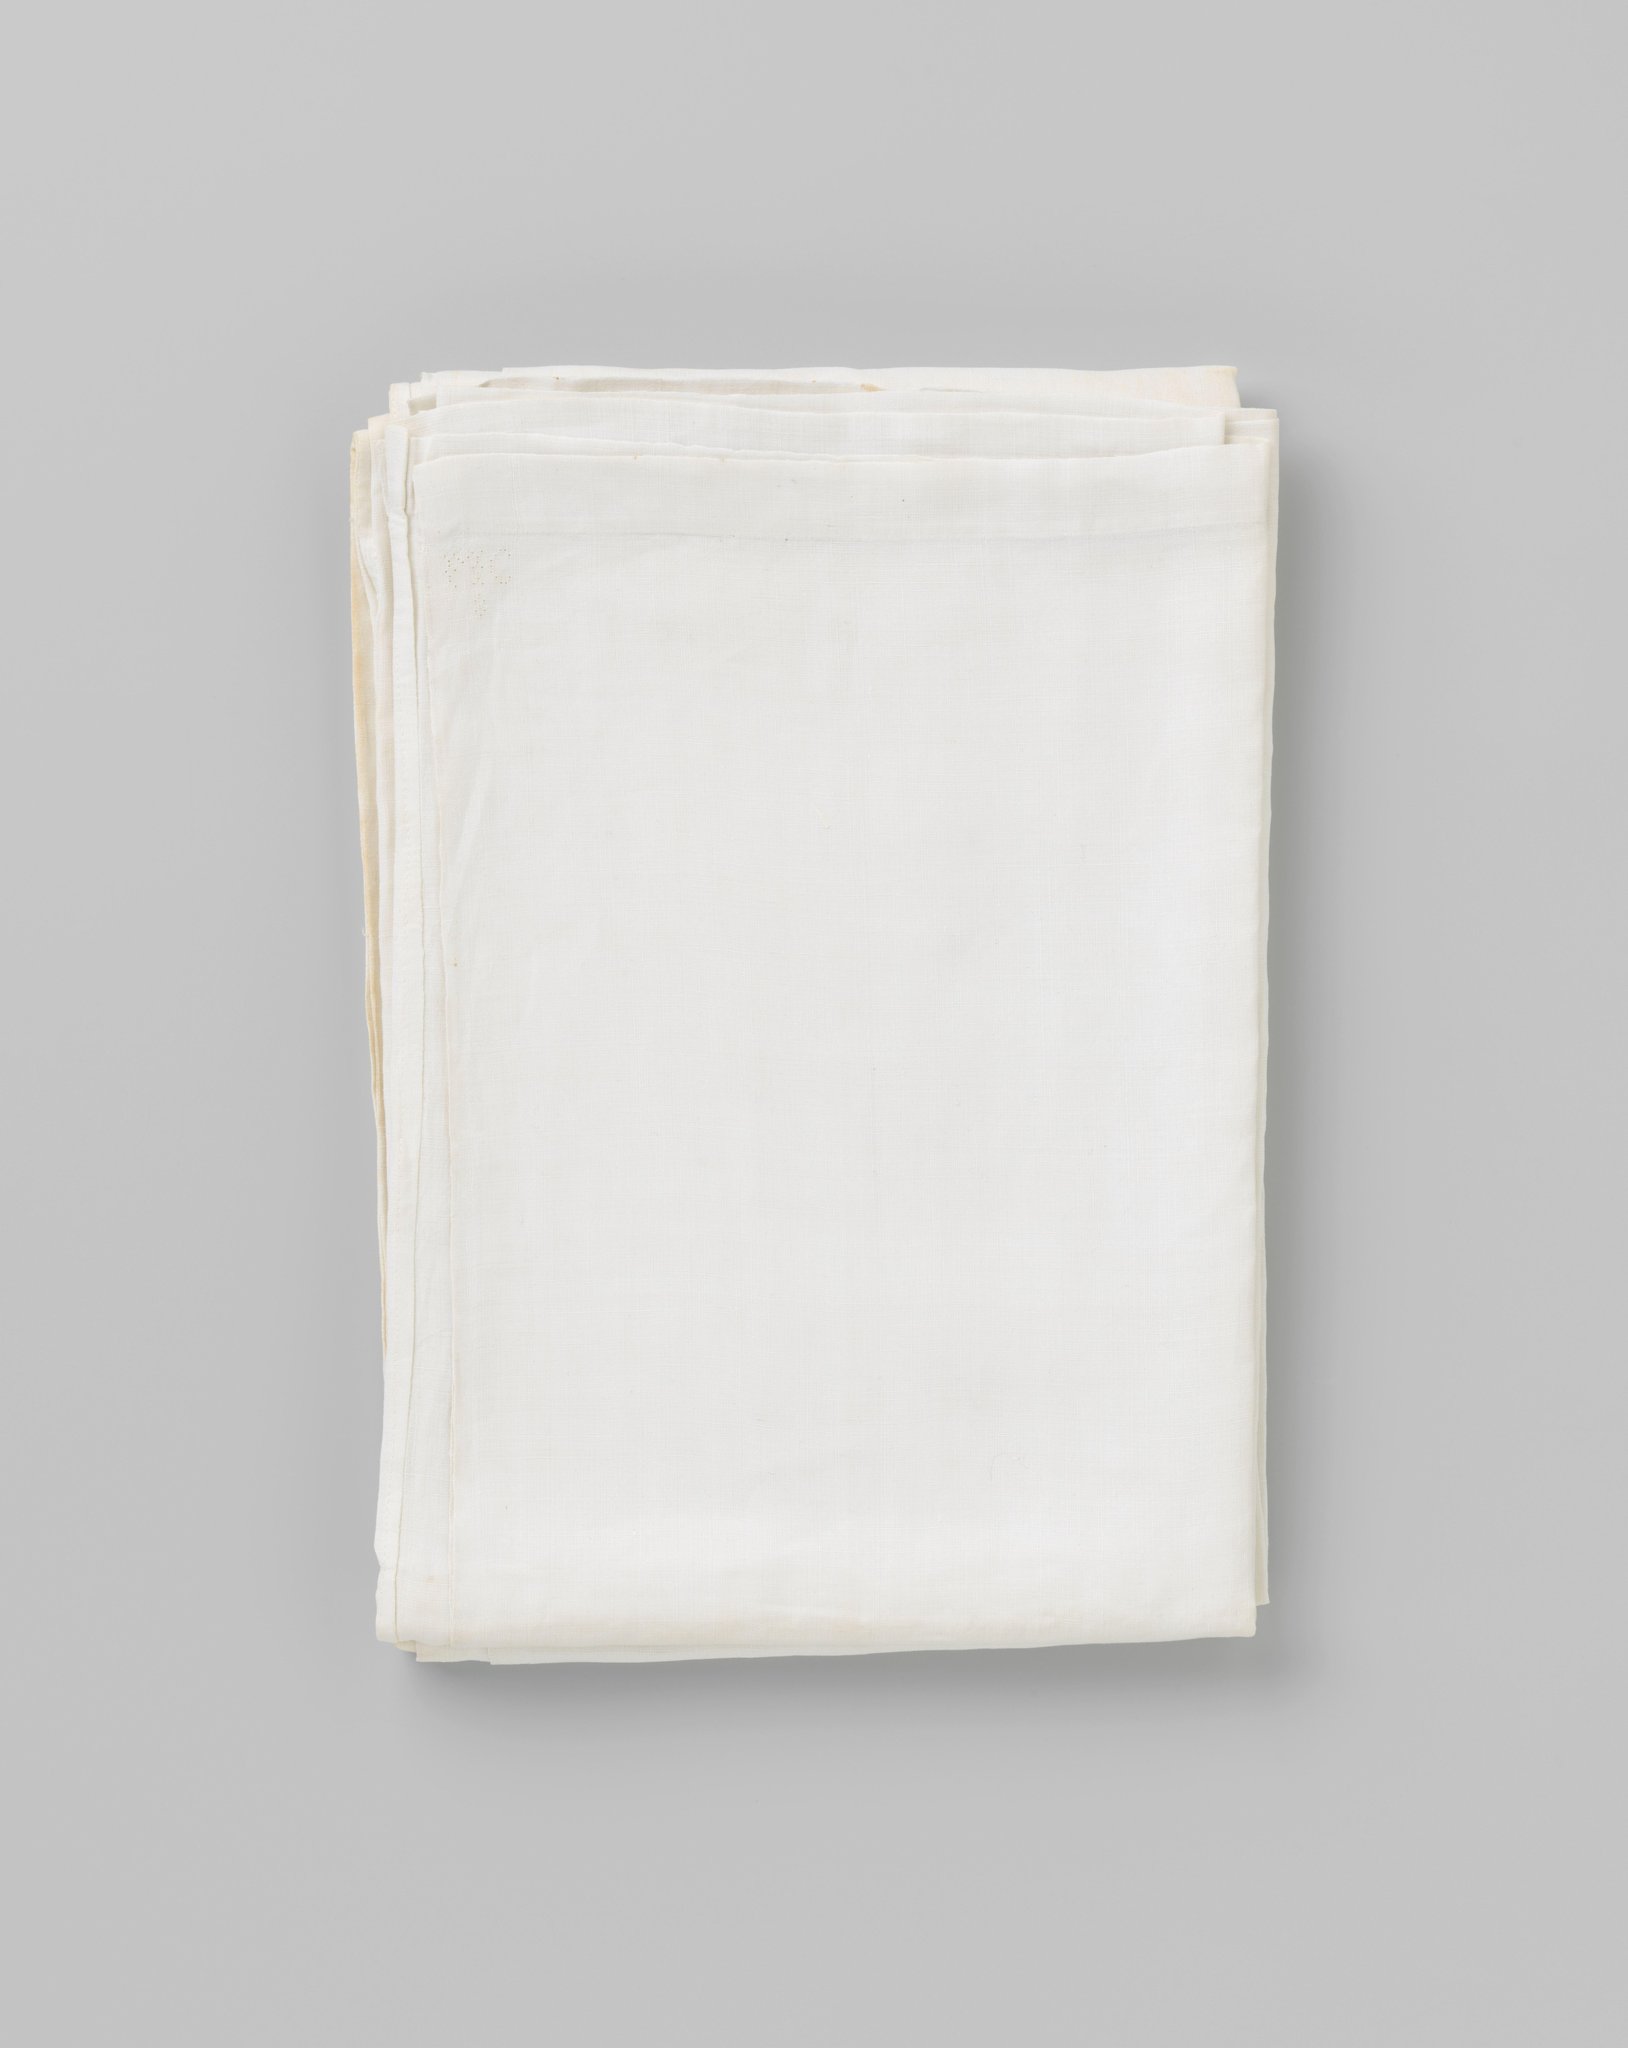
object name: beddenlaken, laken object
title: Laken, gemerkterk: MC8 (Muller/Cats)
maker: Anonymous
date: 1821-1837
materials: linen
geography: netherlands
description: Beddenlaken van linnen met blindmerk MC8 (Mulier-Cats). N.B.: Mr. Gerrit Nicolaas Mulier (1791-1861) trouwt in 1821 Petronella Catharina Cats (1798-1837).